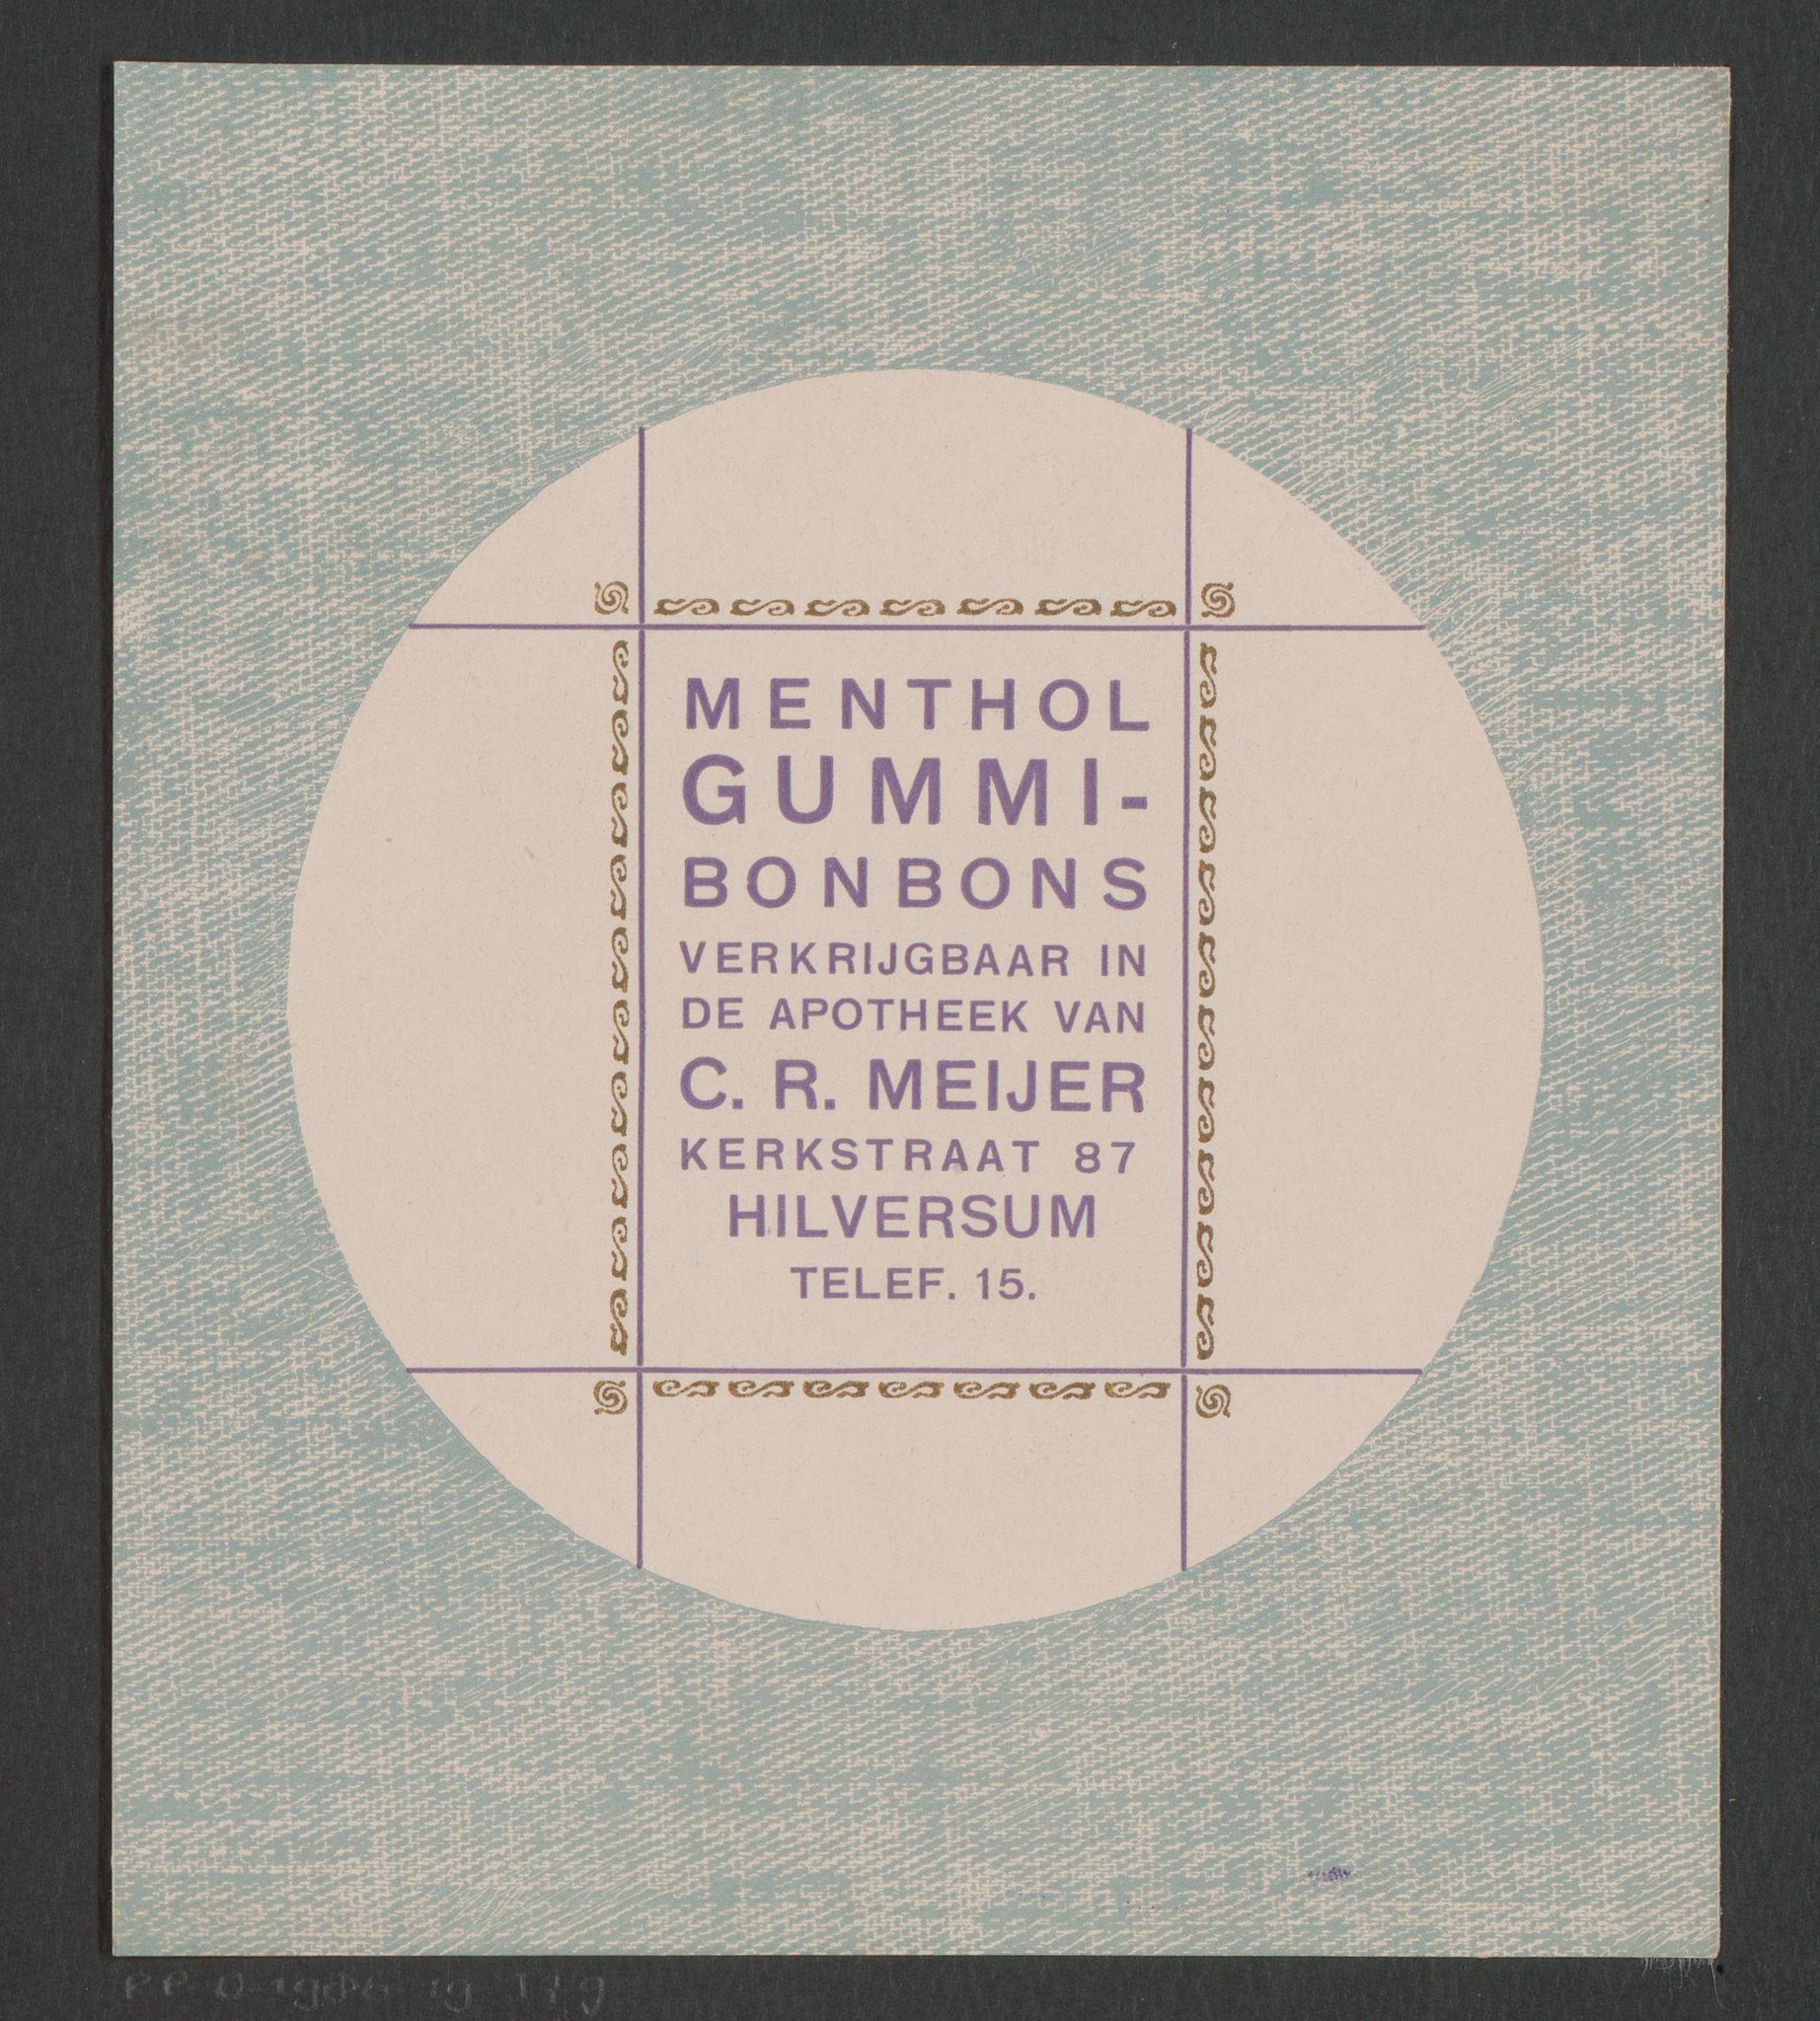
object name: photomechanical print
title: Advertentie voor menthol gummibonbons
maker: reinier willem petrus de vries (1874-1953)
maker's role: draughtsman, print maker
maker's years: 1874-1953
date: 1884-1952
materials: paper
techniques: printing block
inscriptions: collector's mark: ‘R:MVS.’